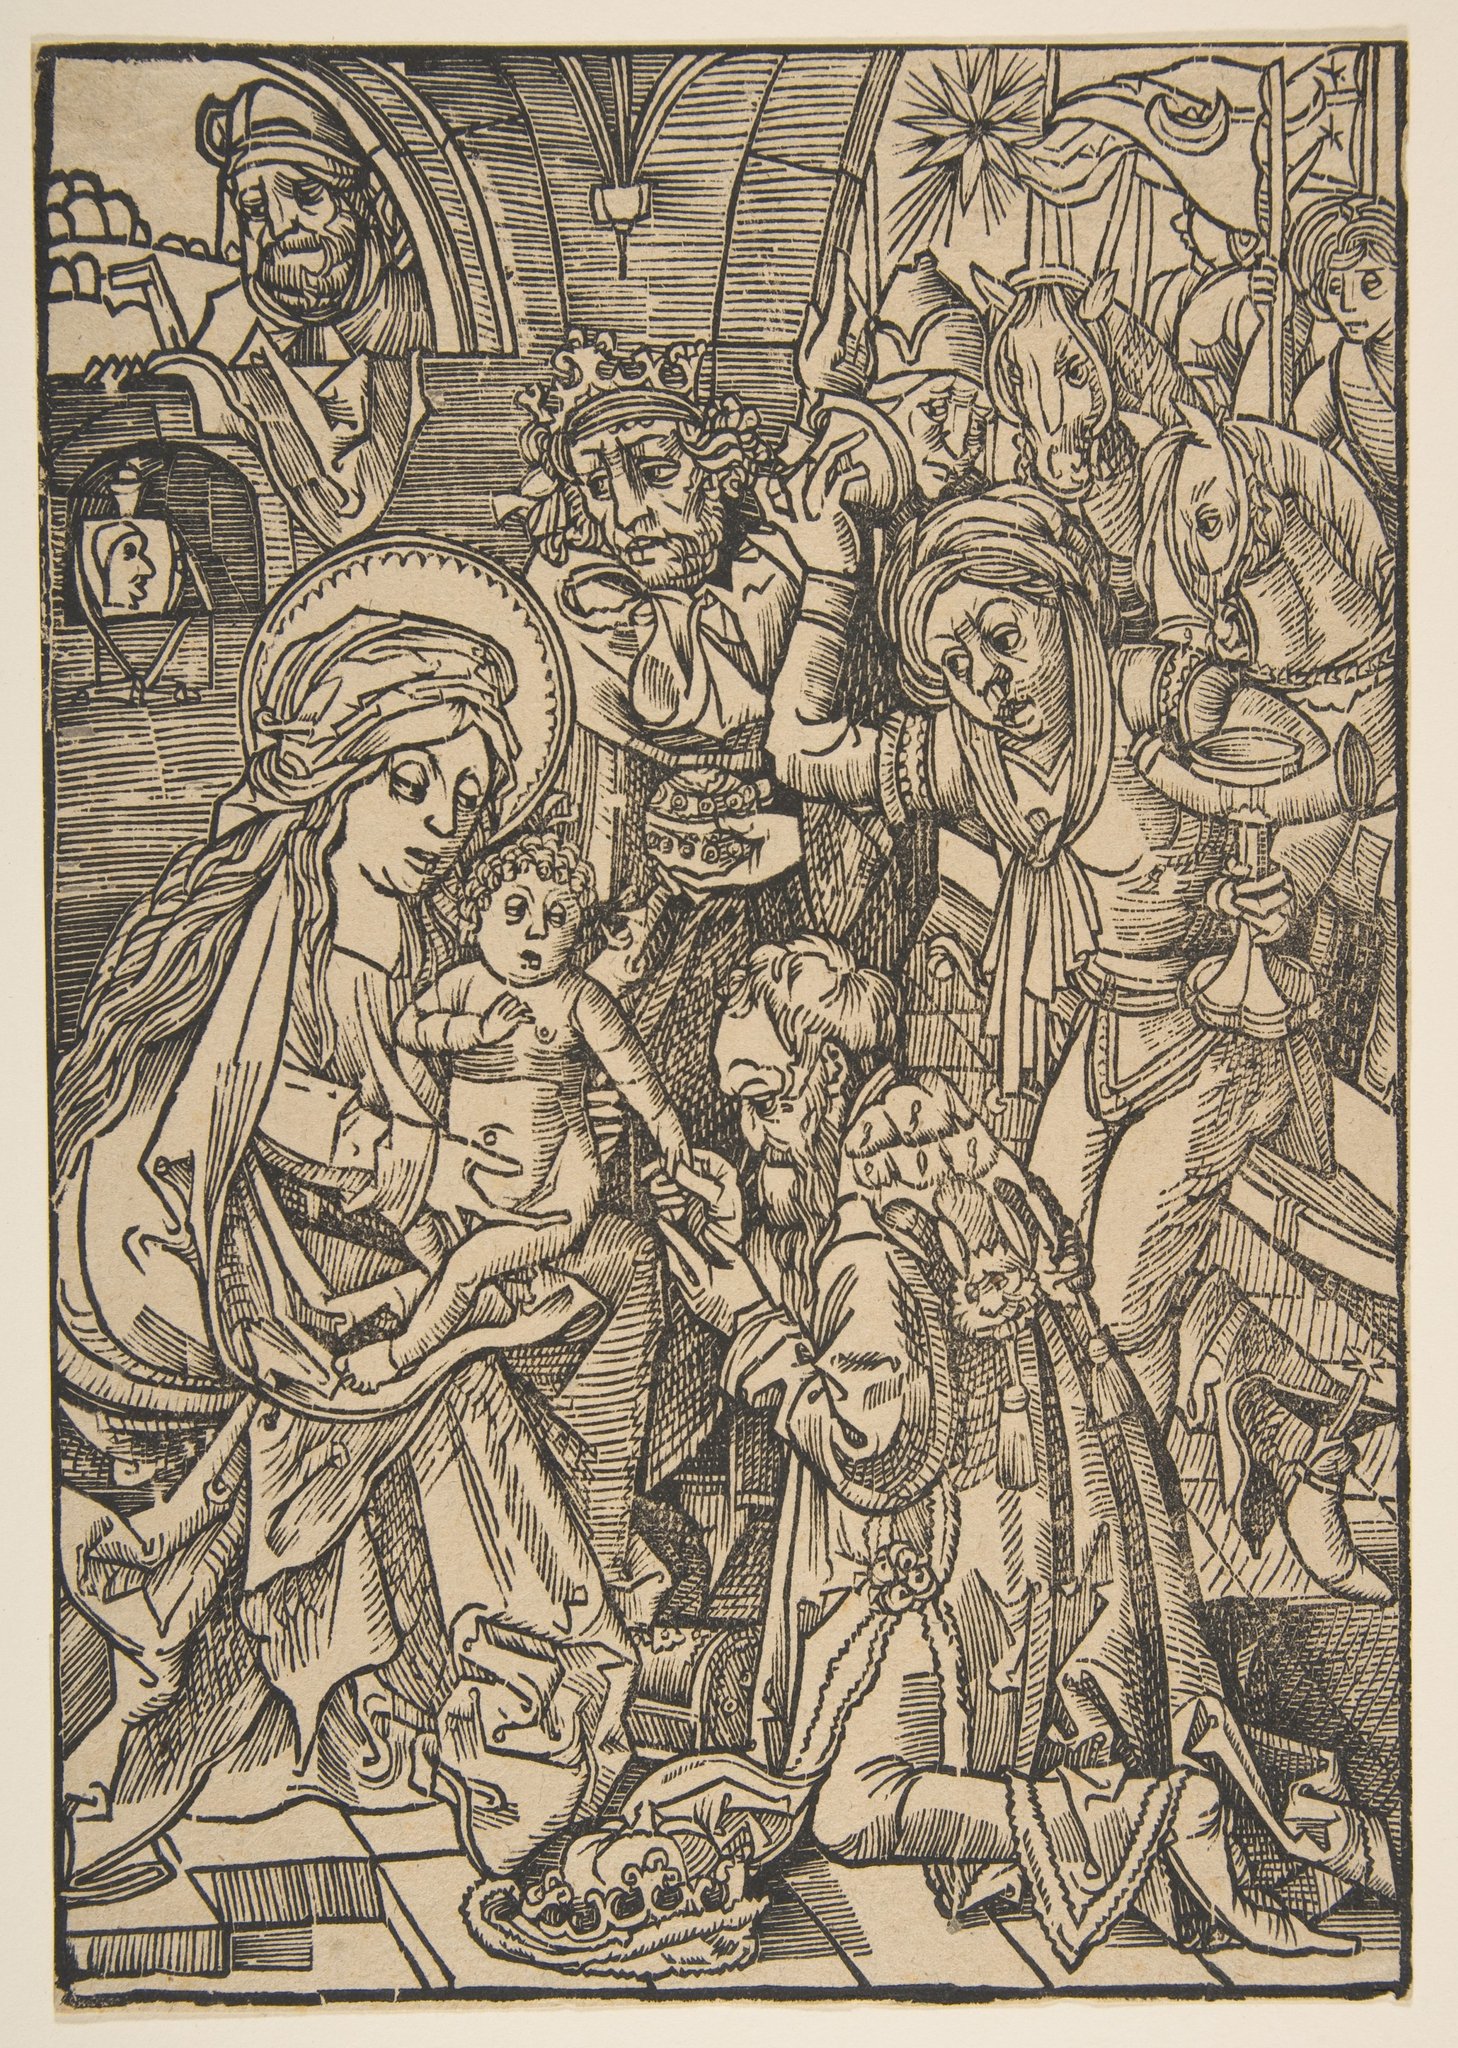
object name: print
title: The Adoration of the Magi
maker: anonymous, german, 15th century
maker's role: artist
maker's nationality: german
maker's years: 1400-1500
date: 1401-1500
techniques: woodcut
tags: men,women,horses,madonna and child,adoration of the magi